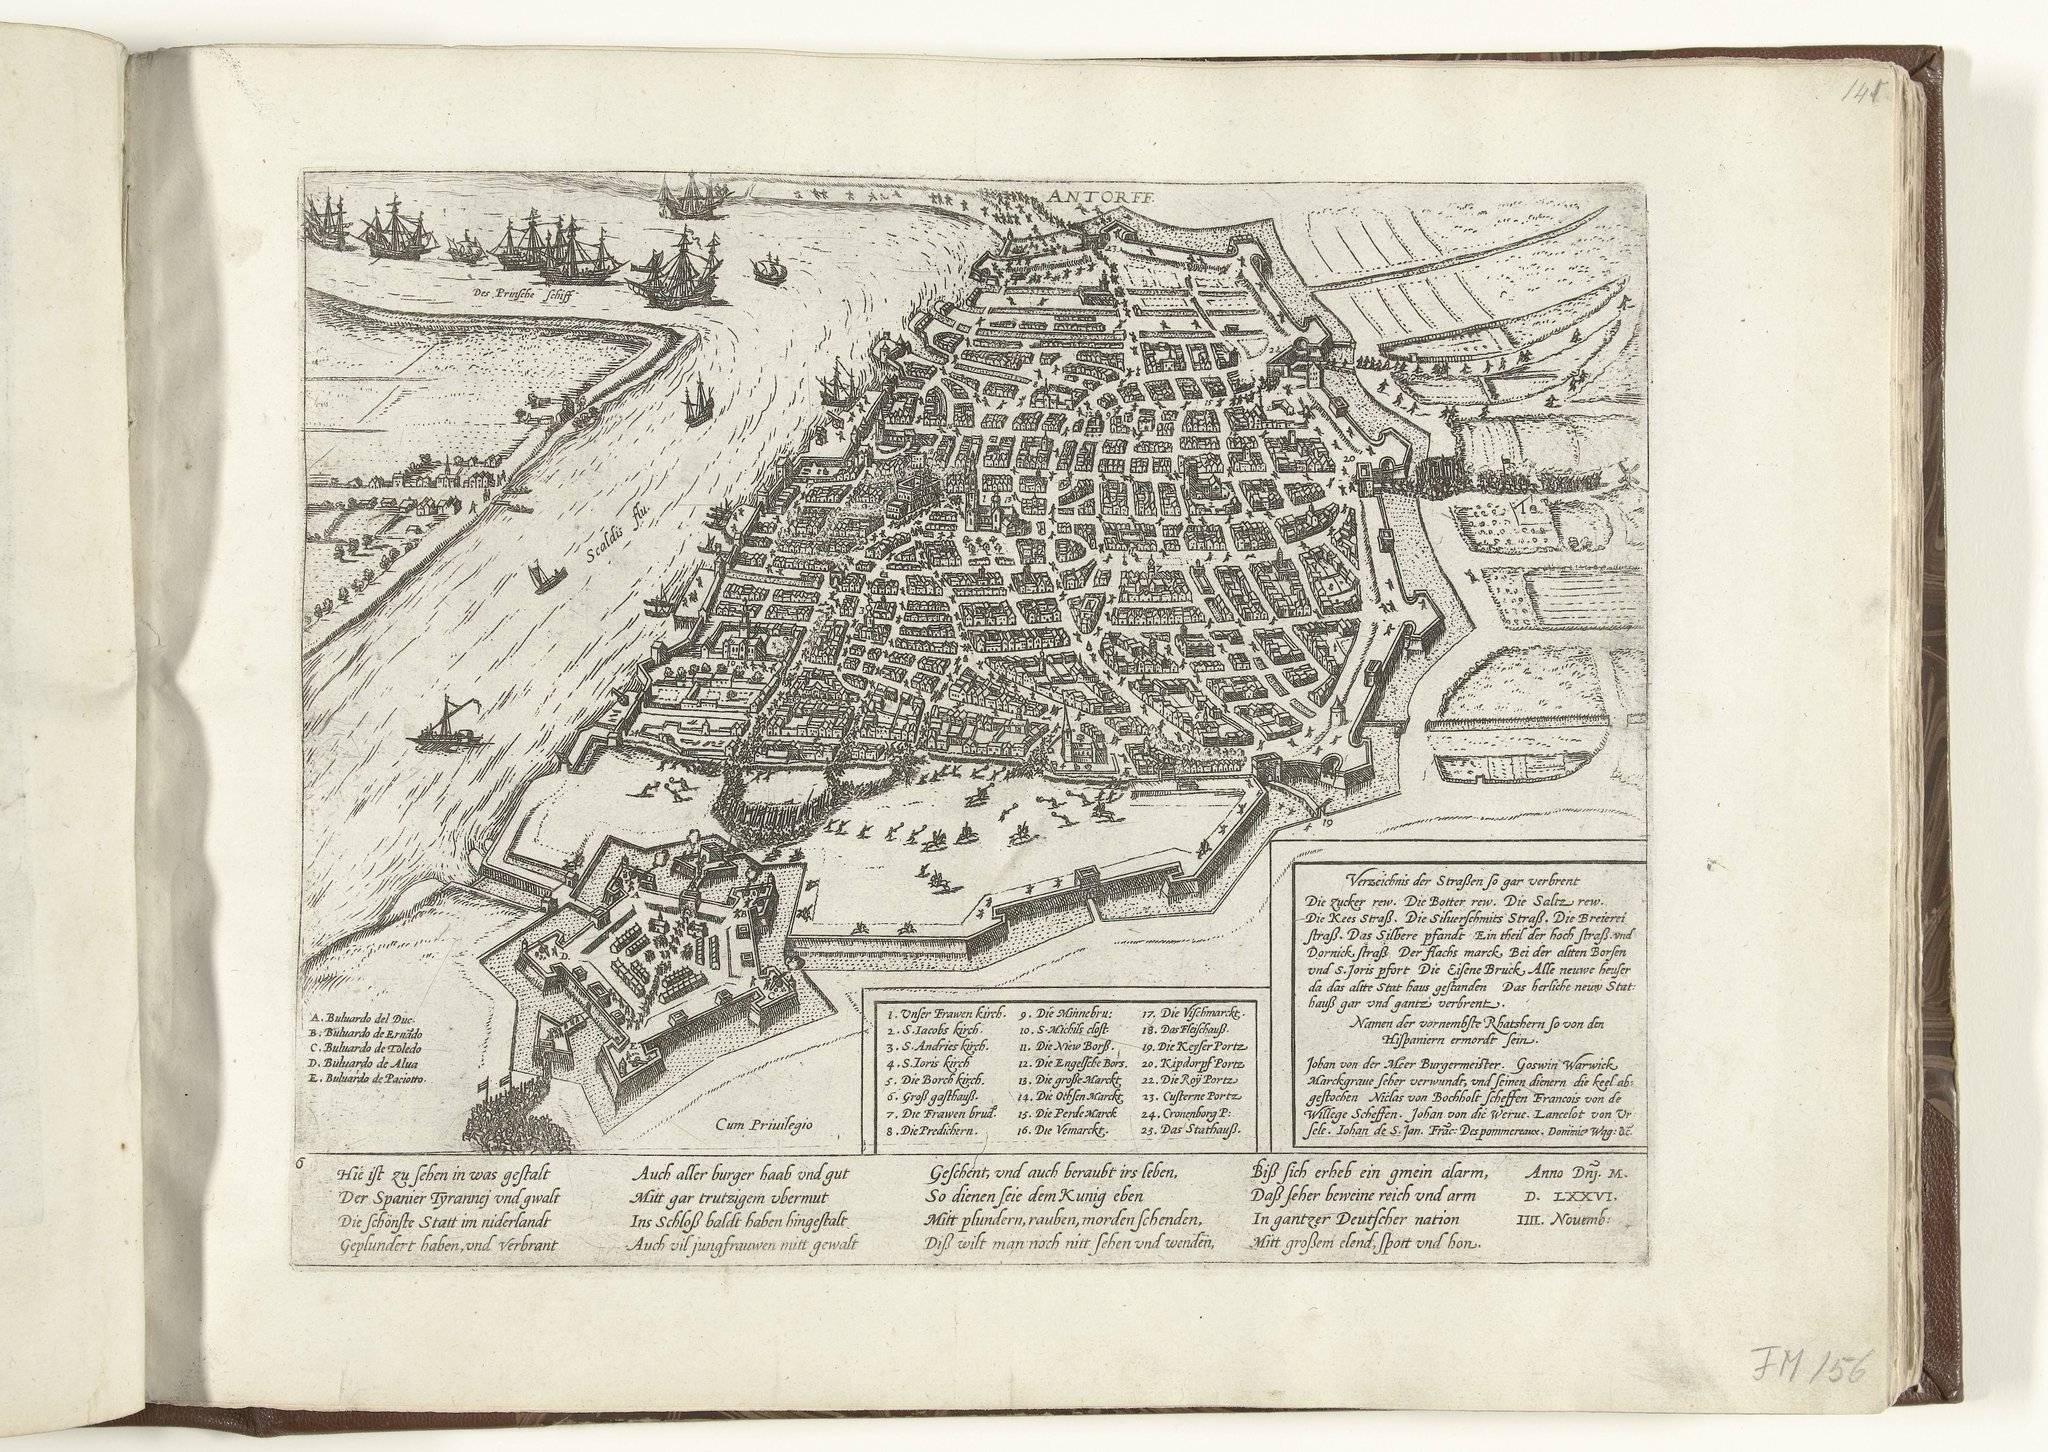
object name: print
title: Serie 7: Nederlandse Gebeurtenissen, 1576-1577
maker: frans hogenberg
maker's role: print maker, publisher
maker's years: 1538-1590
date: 1576-1578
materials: paper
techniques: etching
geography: cologne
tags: maps of cities, massacre ~ war, antwerp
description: Plattegrond van de stad Antwerpen in vogelvluchtperspectief. Vanuit de citadel bestormen de Spaanse soldaten de stad. In twee cartouches een lijst van de belangrijkste gebouwen van de stad (1-25) en een lijst van de straten en huizen verbrand tijdens de plundering en de voornaamste raadsheren gedood door de Spanjaarden. Links onder de namen van de vijf bolwerken van de citadel (A-E). Met onderschrift van 16 regels in het Duits. Genummerd: 6.